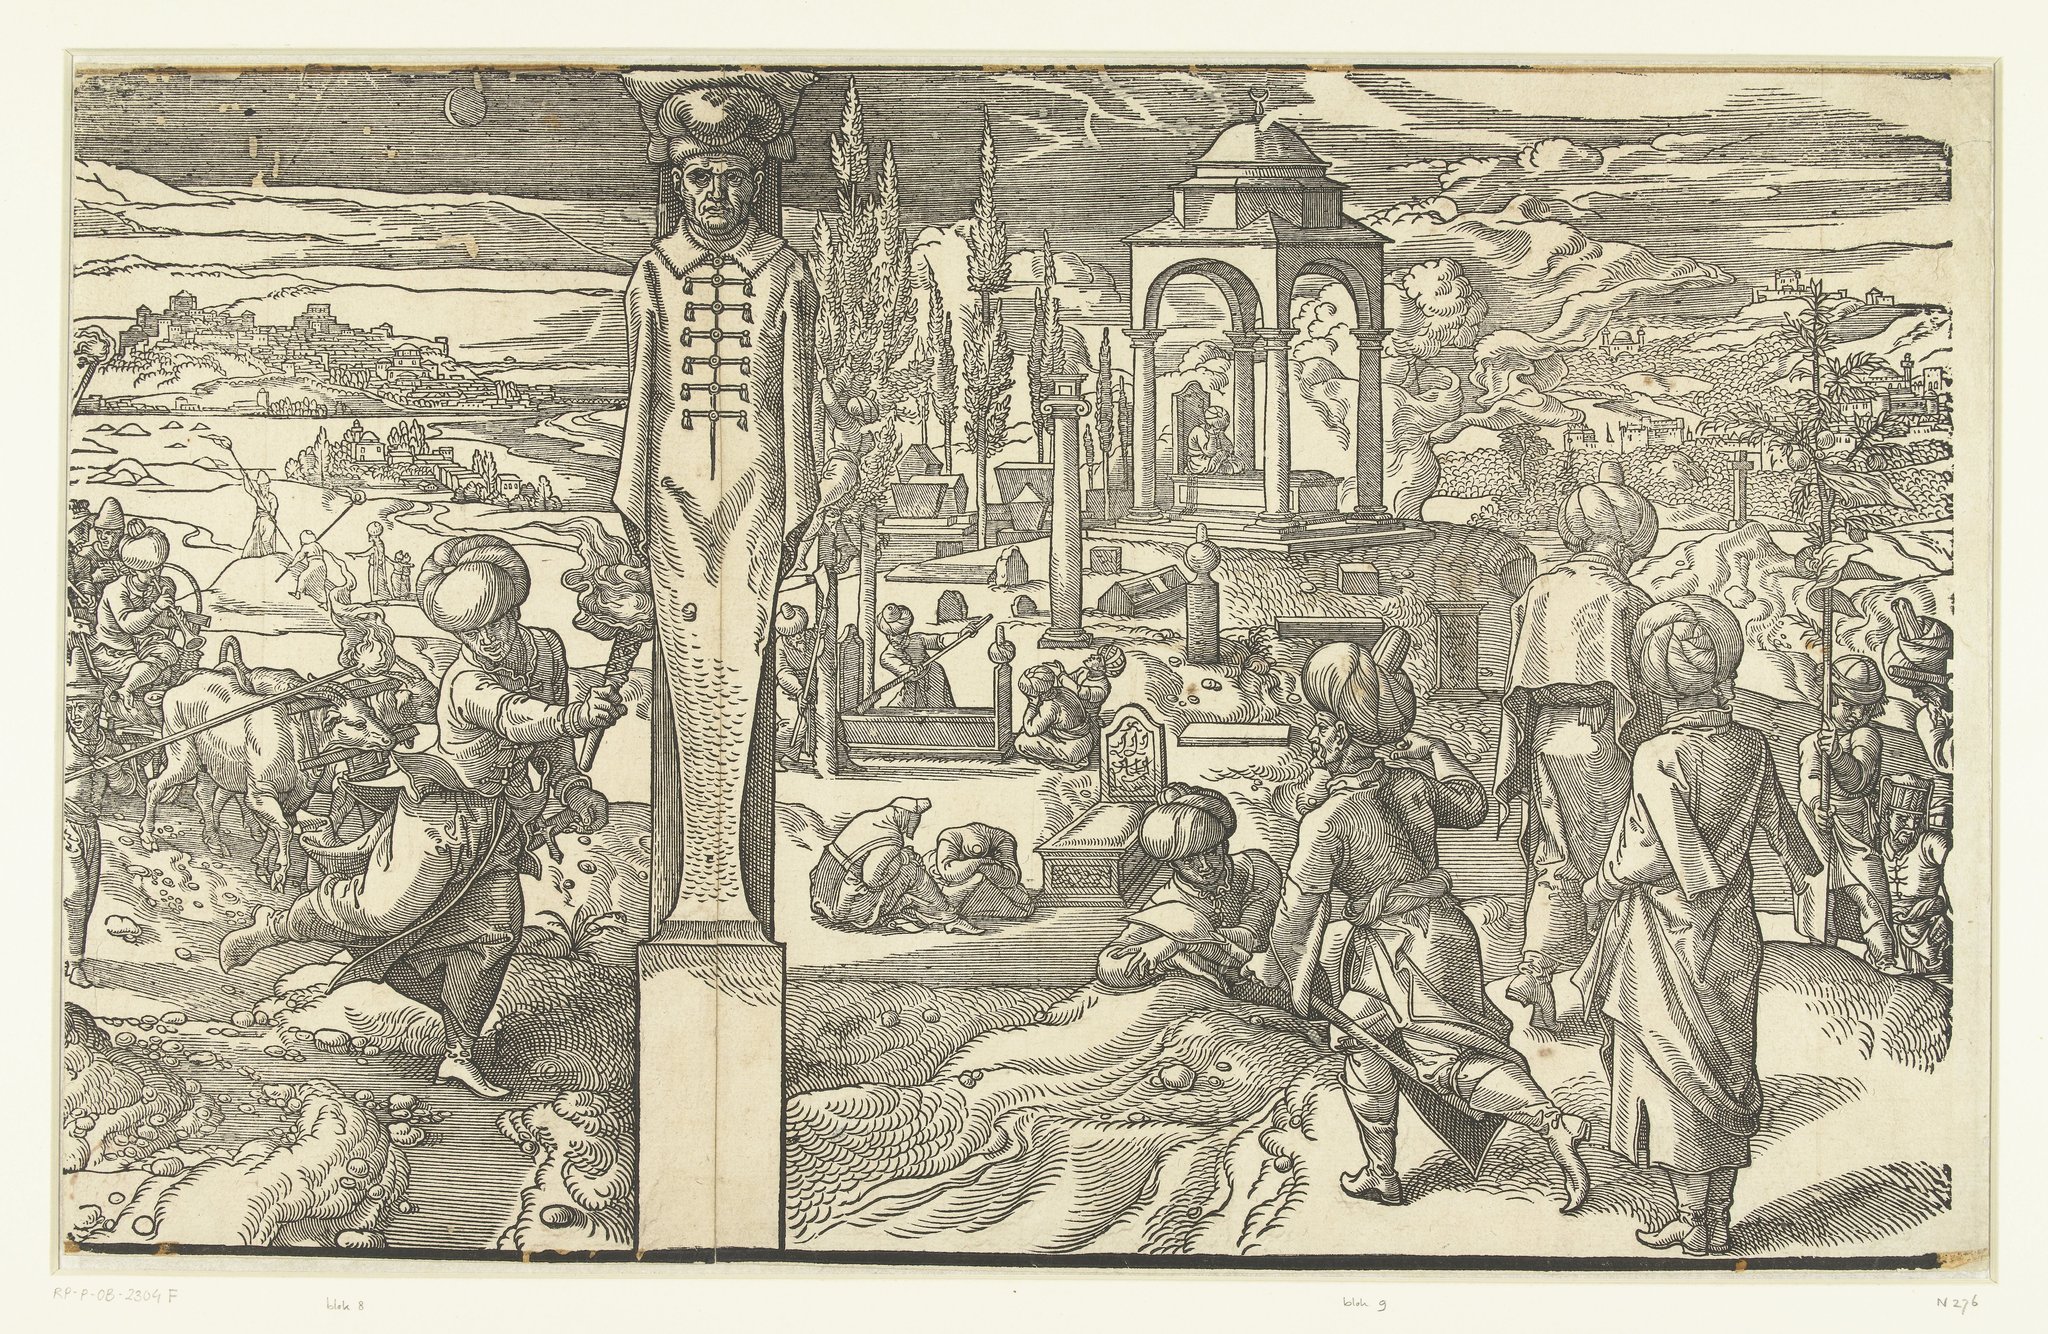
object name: print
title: Feest van de nieuwe maan en begrafenis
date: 1553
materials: paper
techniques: woodcut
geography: low countries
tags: asiatic races and peoples: turks, funerary ritual, ancestor cult ~ islam, mohammedanism, waning moon, i.e. facing this way (, ritual practices ~ islam, mohammedanism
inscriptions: collector's mark: Lugt 240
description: Gedrukt van twee blokken op twee bladen, aan elkaar bevestigd. Achtste en negende blok van veertien, vormen samen een fries van zeven afbeeldingen met de zeden en gewoonten van de Turken. Links het rechter deel van afbeelding van feest van de nieuwe maan, man met fakkel en muzikanten op wagen getrokken door os. Rechts mannen op een begraafplaats. Twee scènes gescheiden door een atlant.